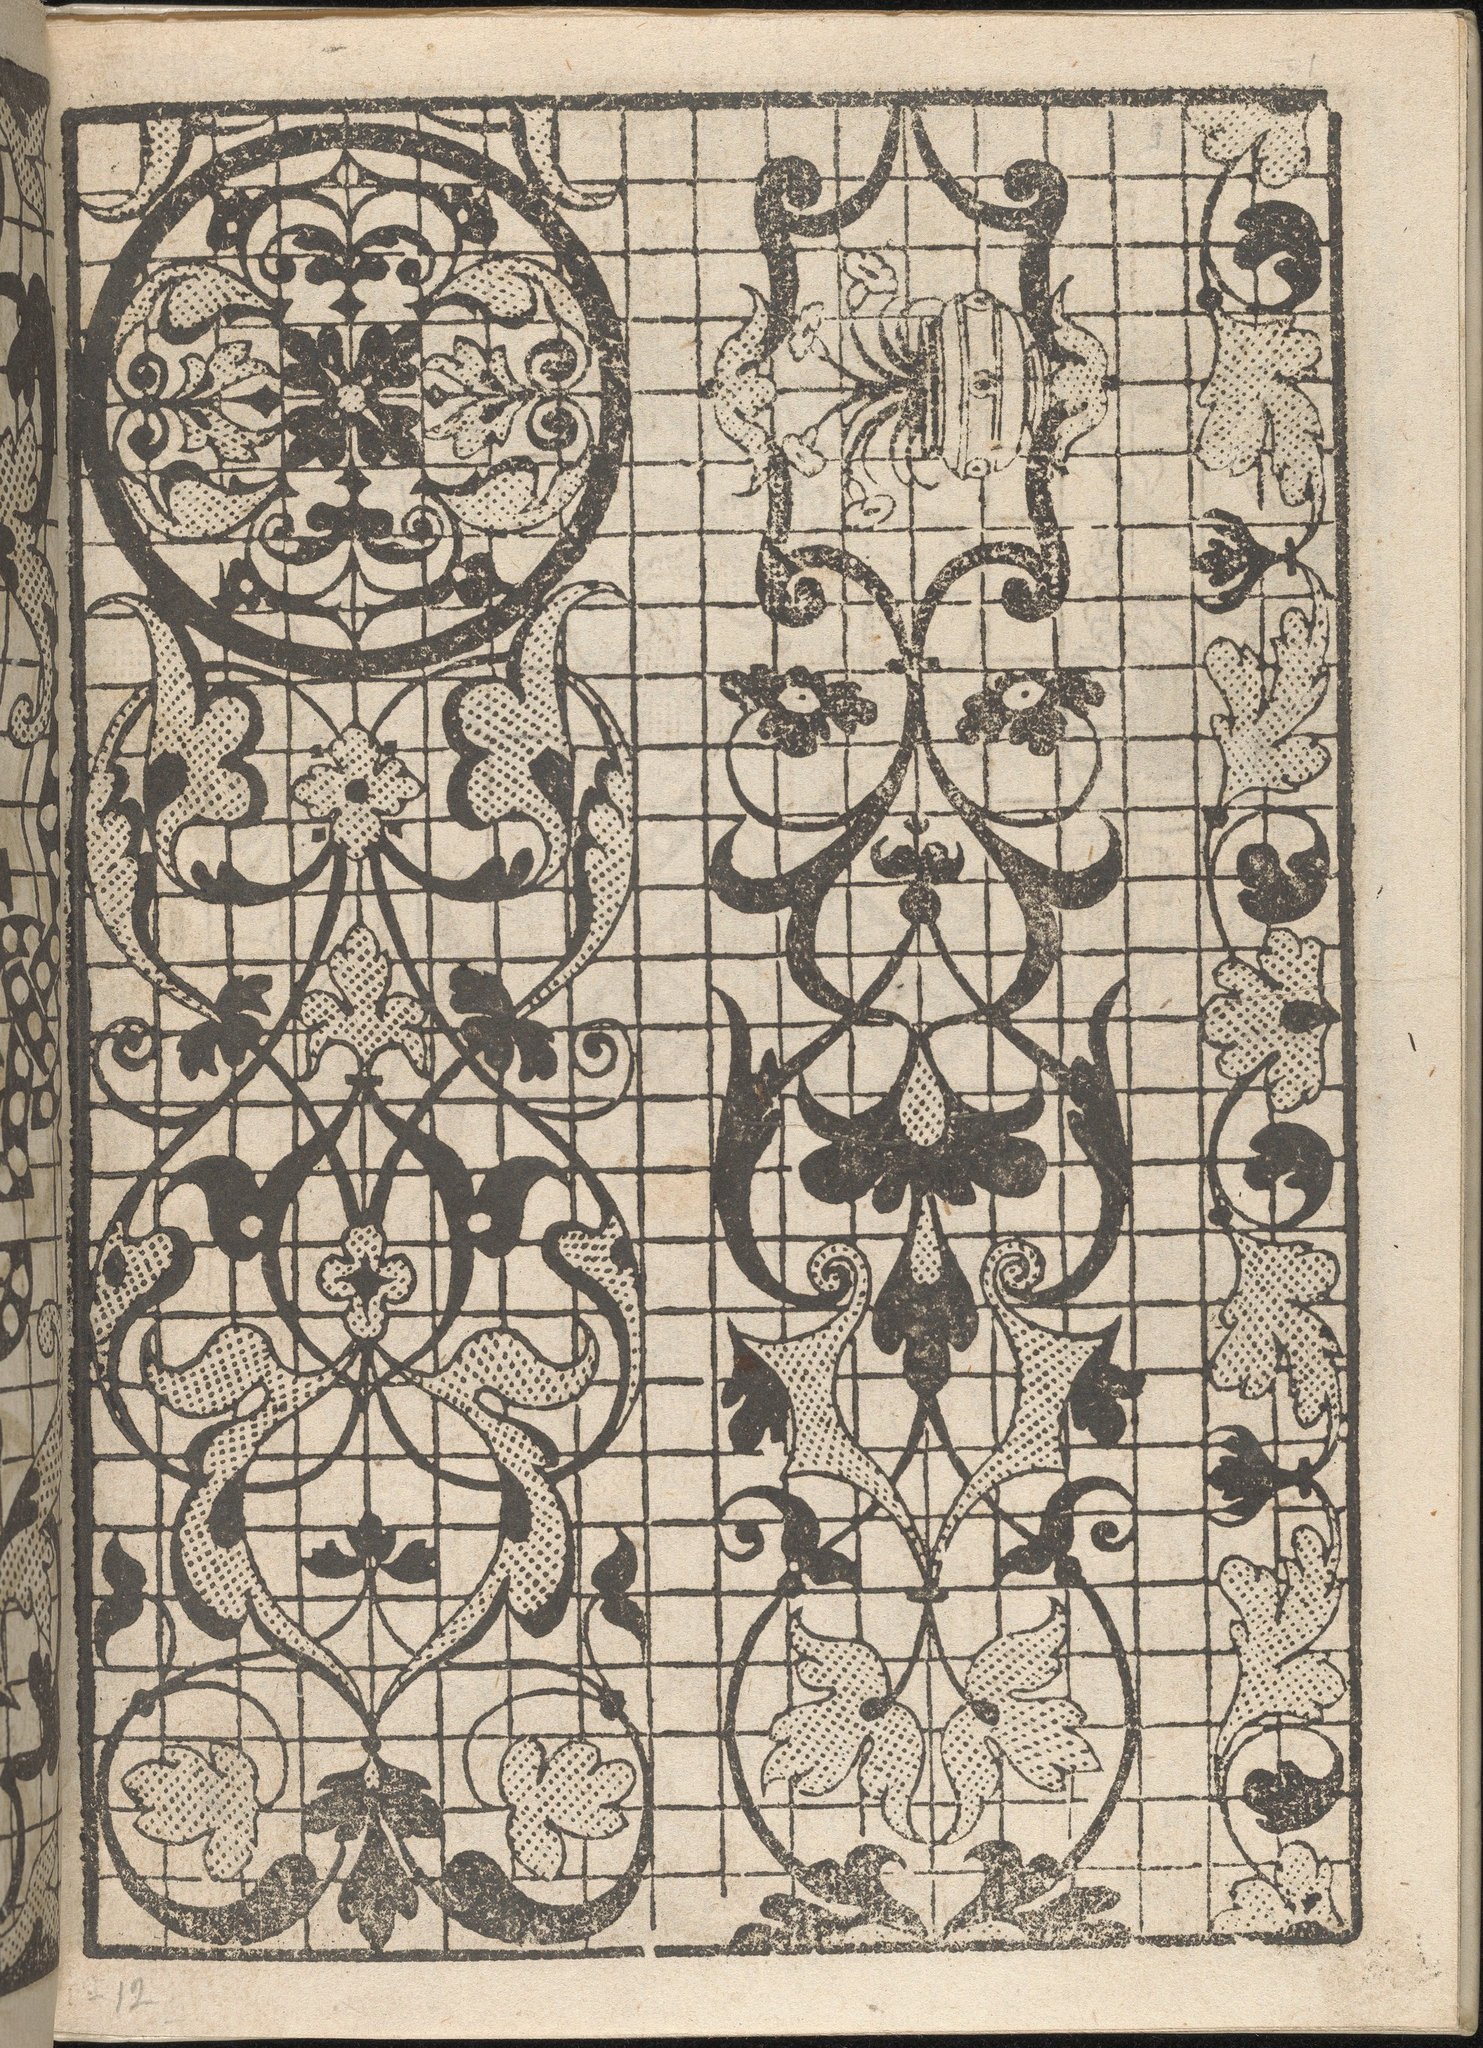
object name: book print ornament architecture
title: Splendore delle virtuose giovani, page 12 (recto)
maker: iseppo foresto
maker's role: designer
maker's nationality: italian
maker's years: 1520-1580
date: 1564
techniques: woodcut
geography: italy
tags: ornament